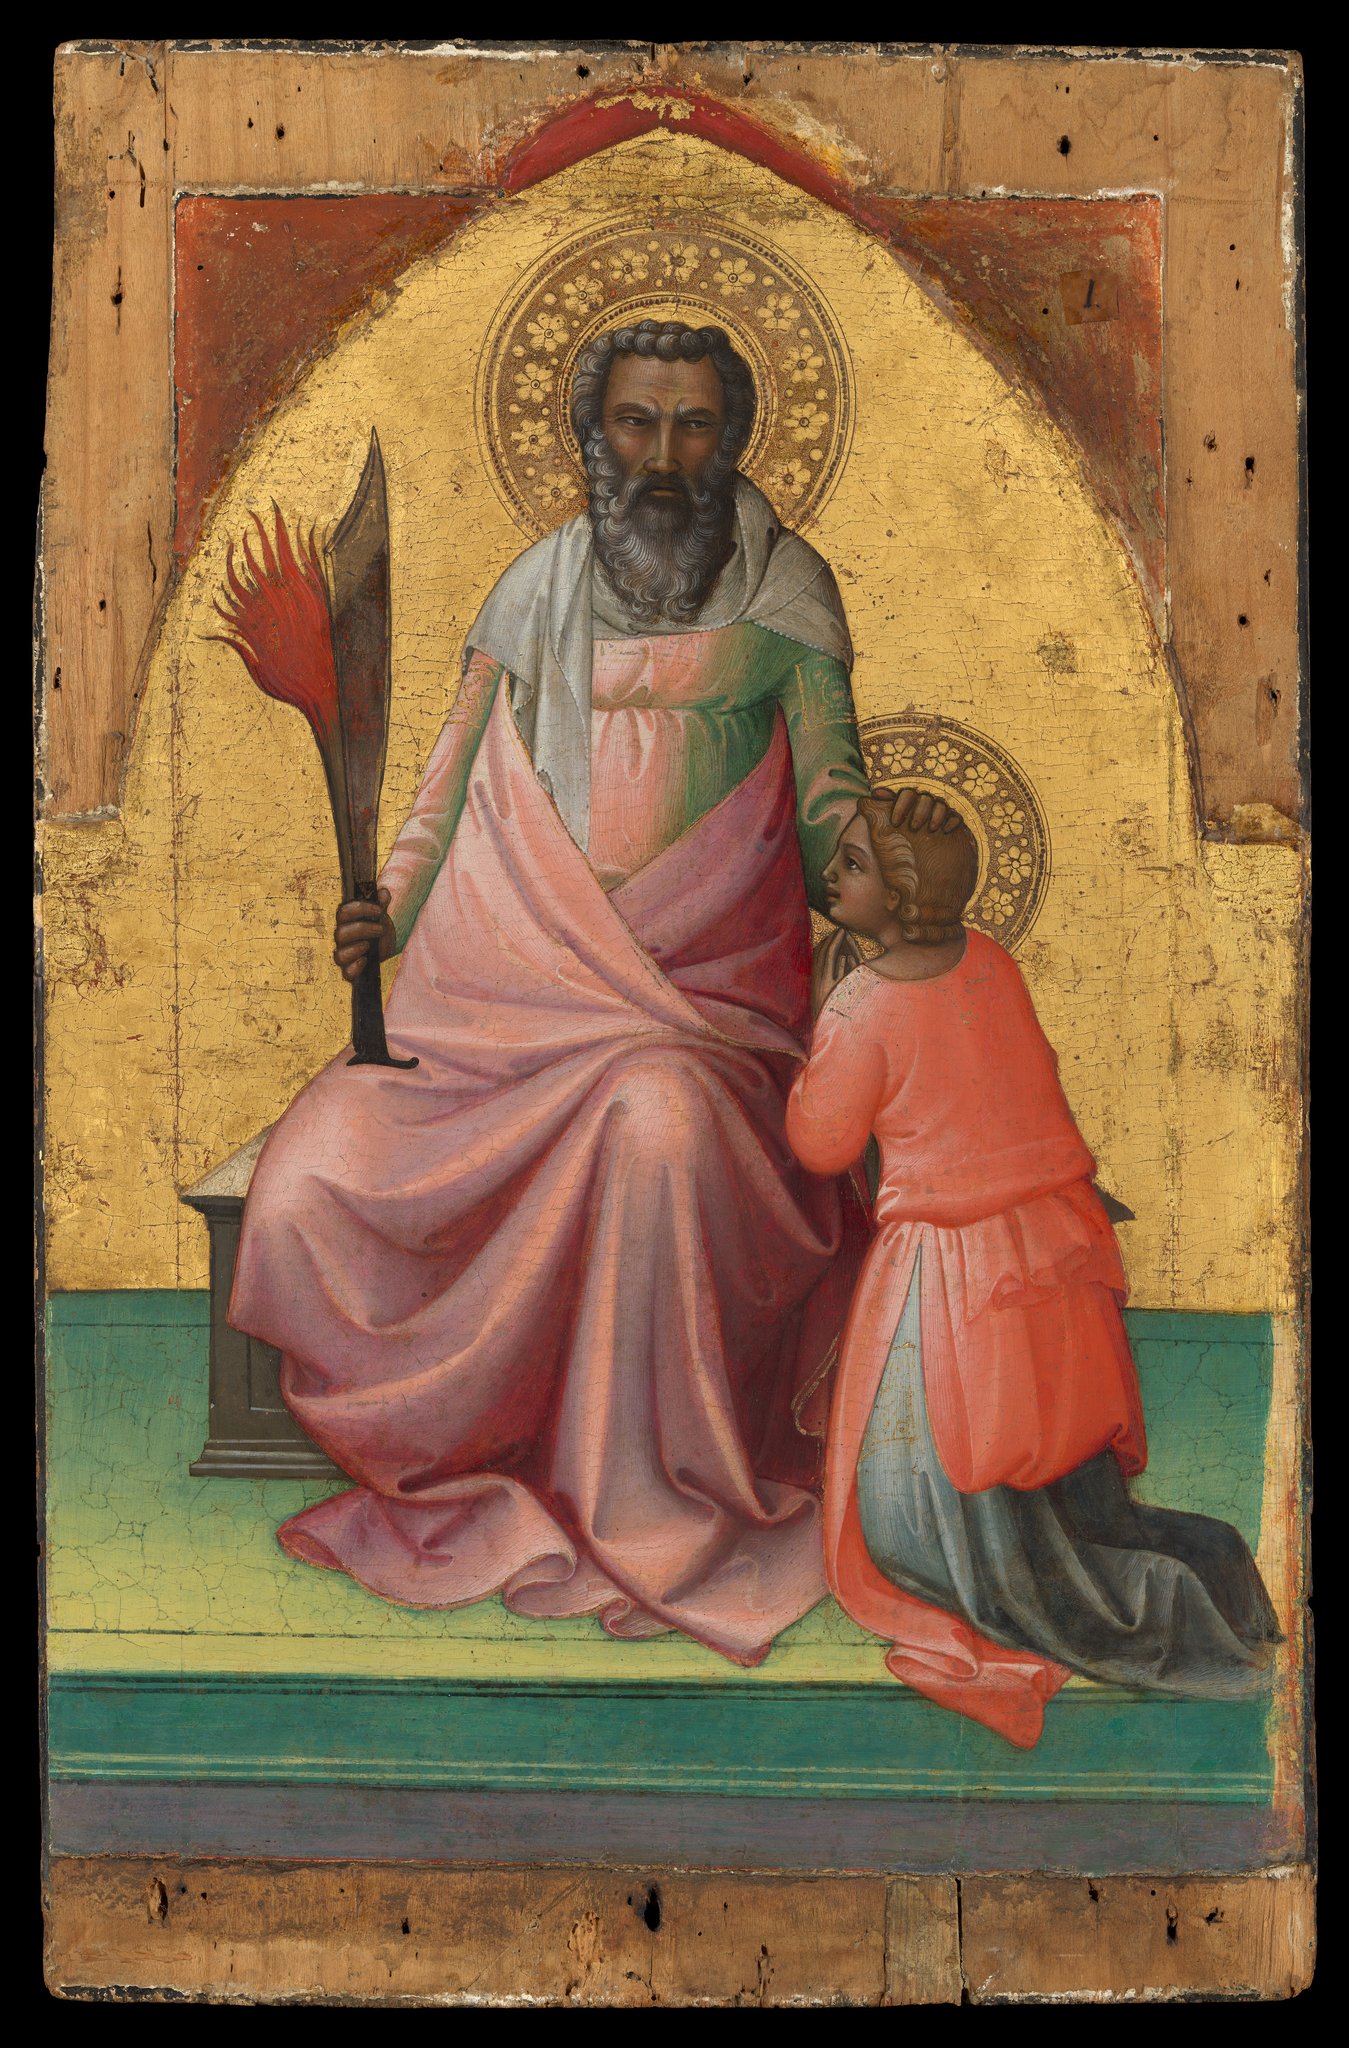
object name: painting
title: Abraham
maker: lorenzo monaco (piero di giovanni)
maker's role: artist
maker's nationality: italian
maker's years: 1370-1425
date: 1408-1410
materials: gold leaf, paint, wood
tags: men,abraham